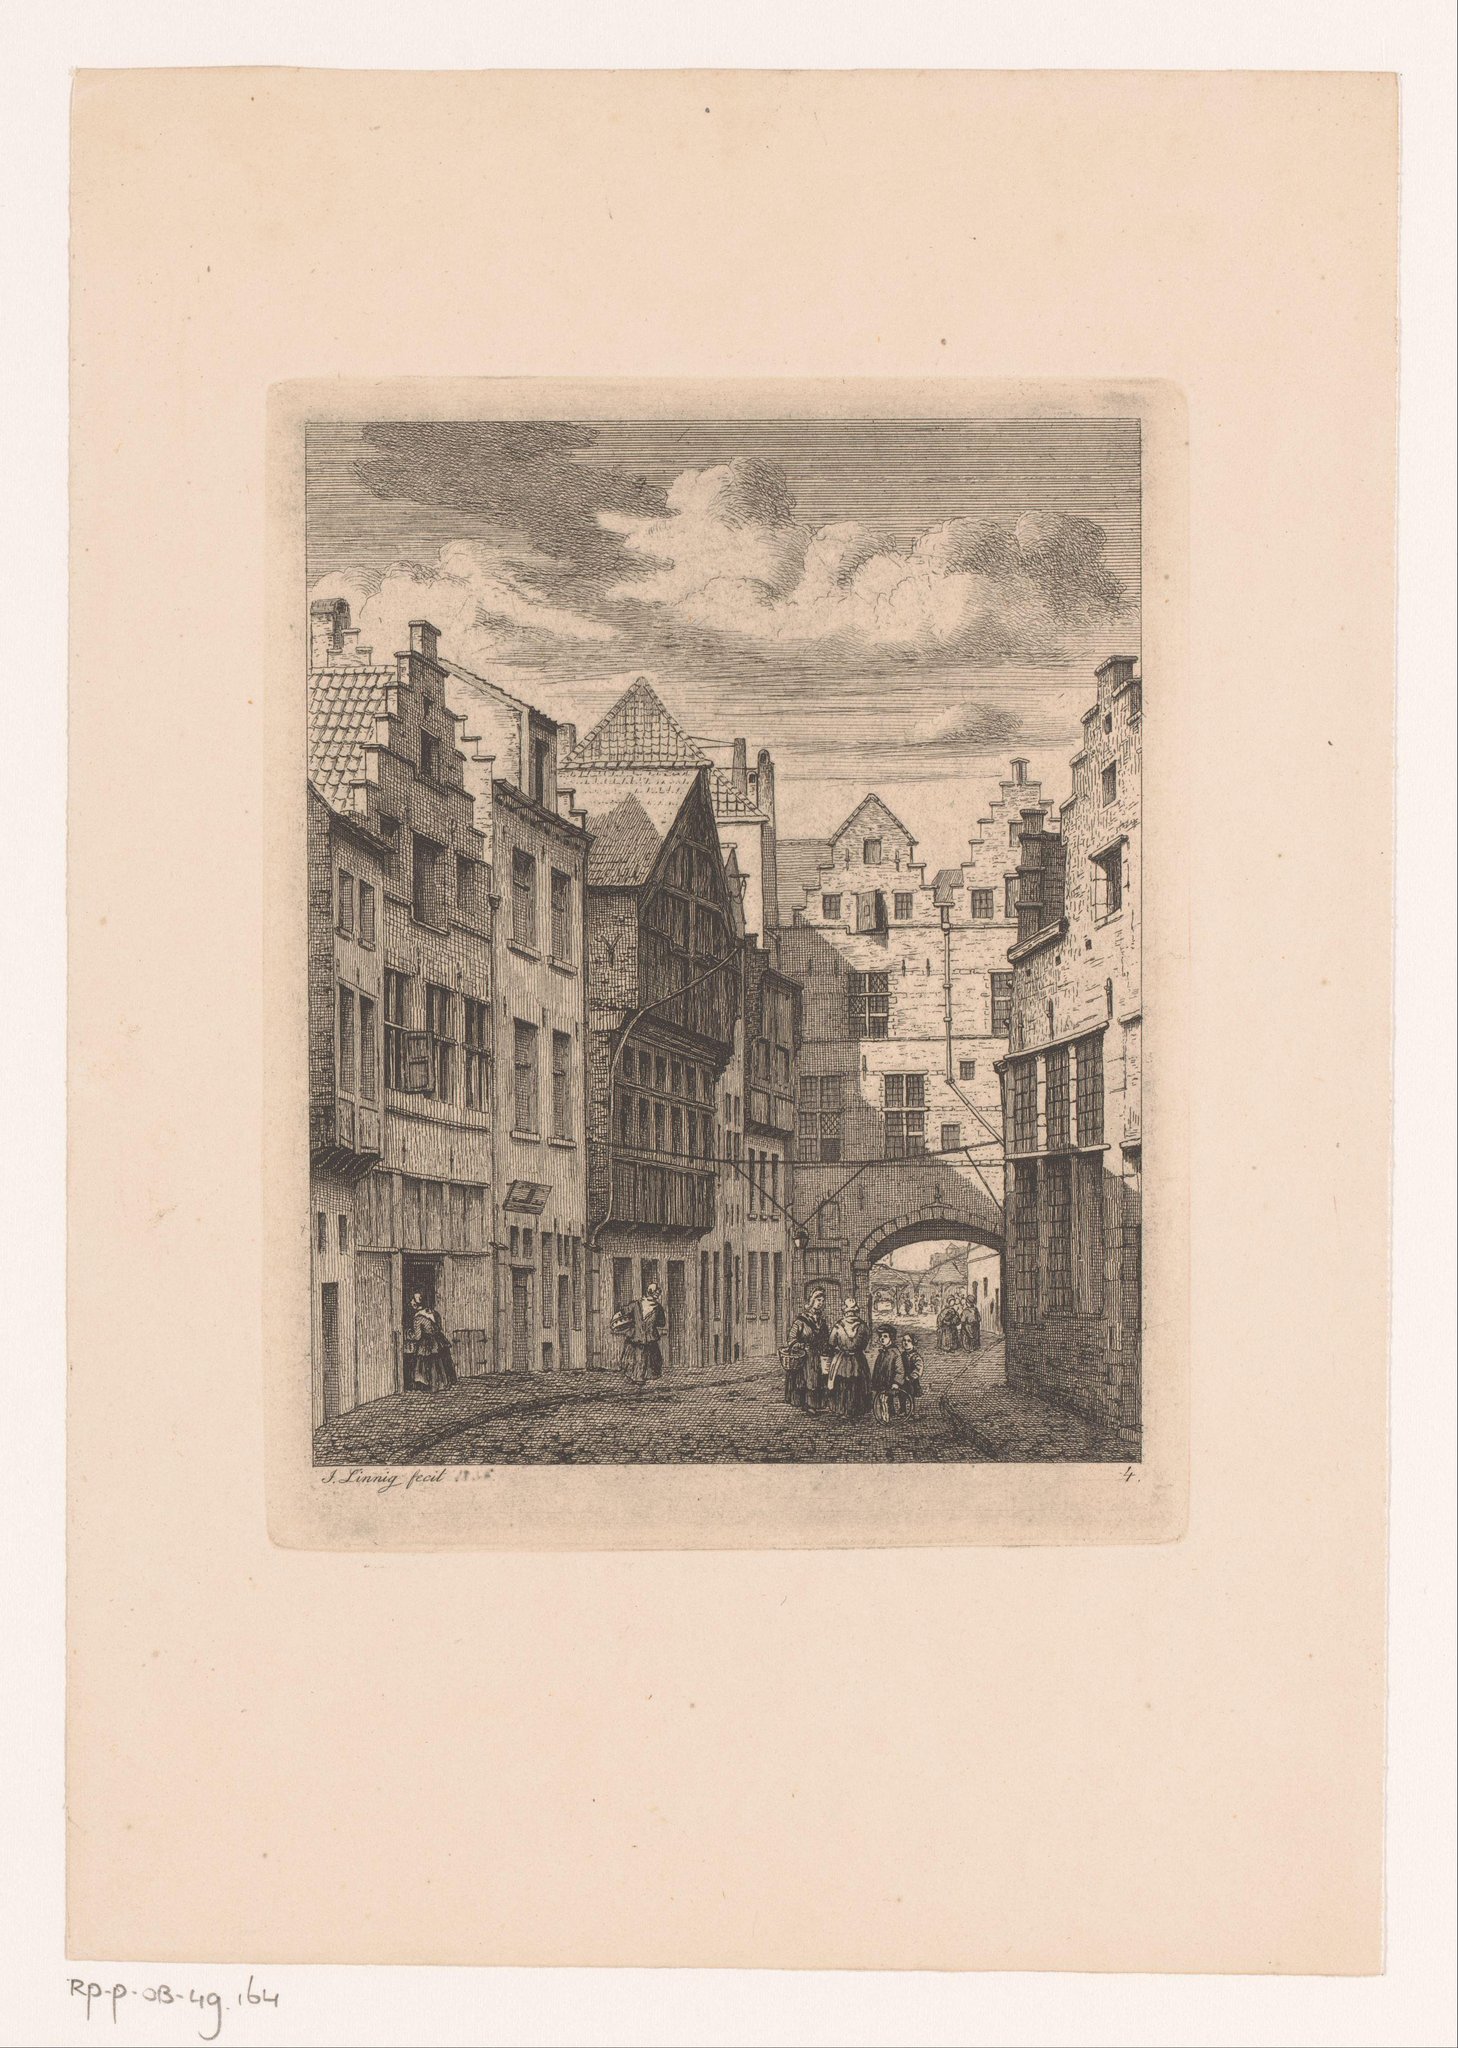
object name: print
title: Gezicht op de Palingbrug in Antwerpen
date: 1868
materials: paper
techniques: etching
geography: antwerp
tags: city-view in general; 'veduta', antwerp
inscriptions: collector's mark: Lugt 2228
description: Prent uit: Mertens, F.H. Album historique de la ville d'Anvers [...]. Antwerpen: J.E. Buschmann, 1868.